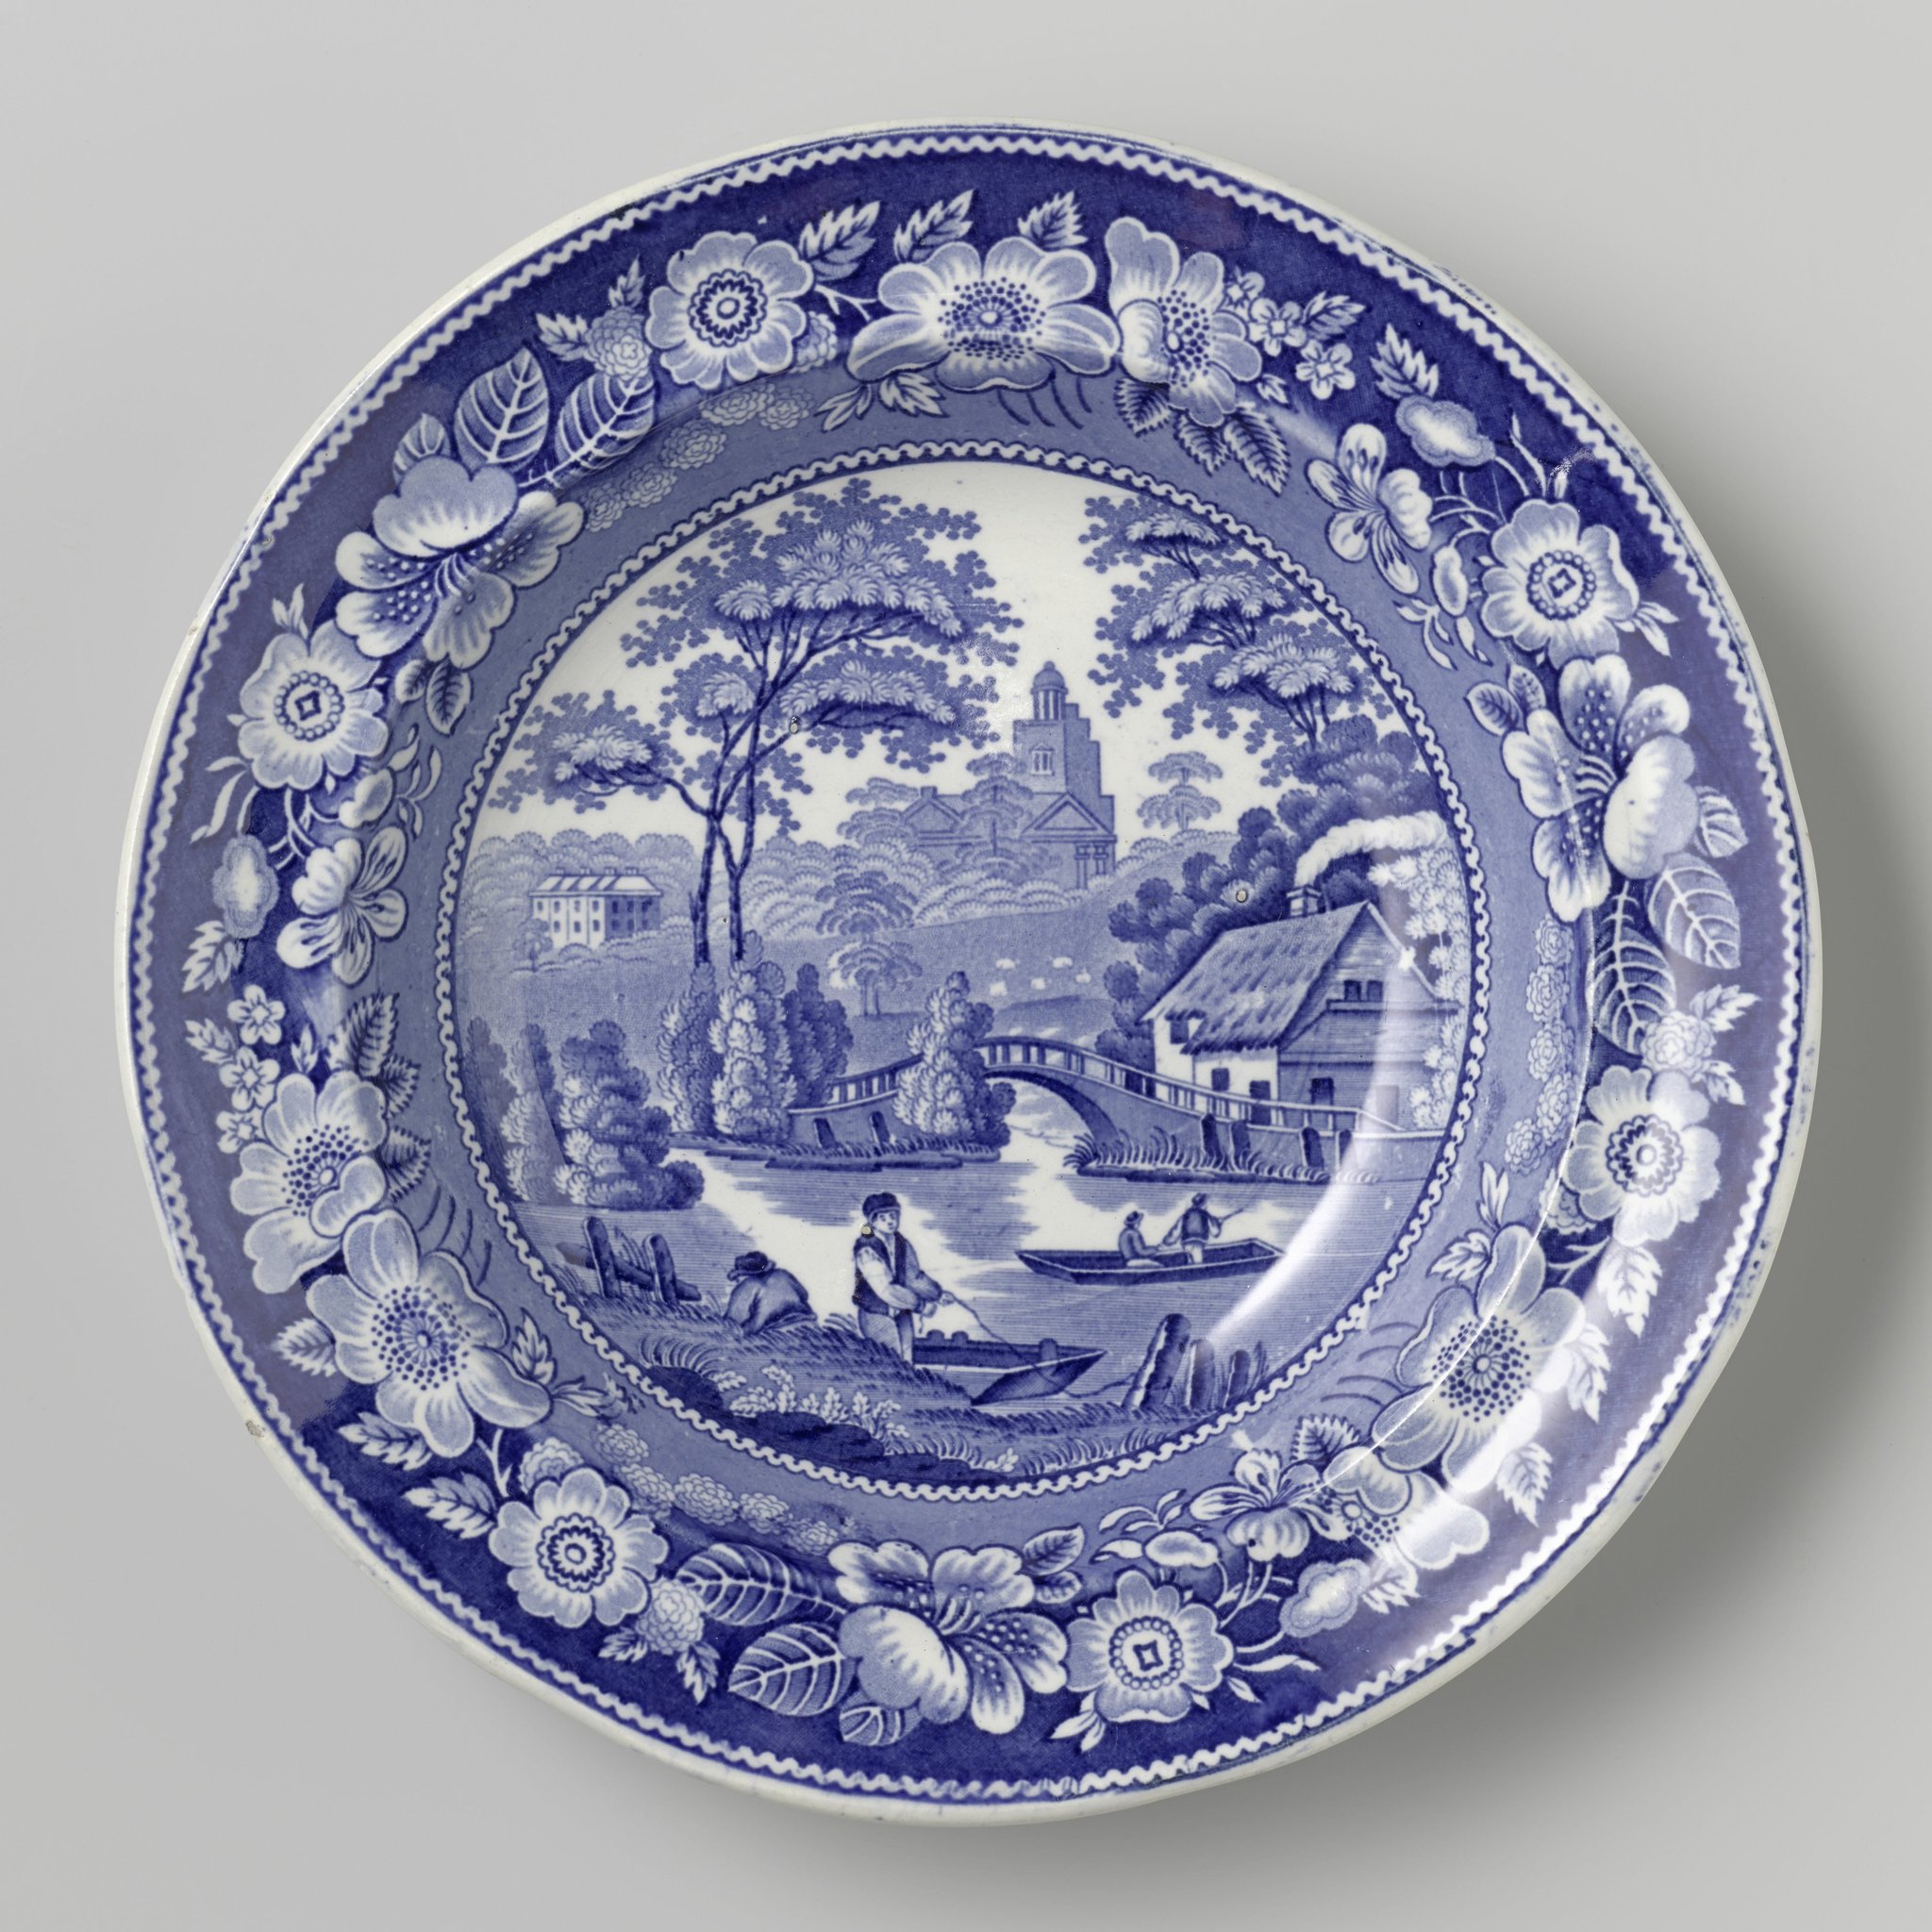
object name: plate dish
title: Bord met op het plat twee keer twee mannen in een boot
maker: Anonymous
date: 1830-1890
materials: earthenware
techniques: transfer decoration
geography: england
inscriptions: check stamp: ‘FELL & CO // anker’, mark: ‘WILD ROSE // T. FELL & CO’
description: Bord van aardewerk met vloeiblauw transferdecor. Op het plat een voorstelling van twee keer twee mannen in een boot, met op de achtergrond een brug en enkele gebouwen. De rand van het bord met een krans van bloemen en bladeren en een golvende bies.